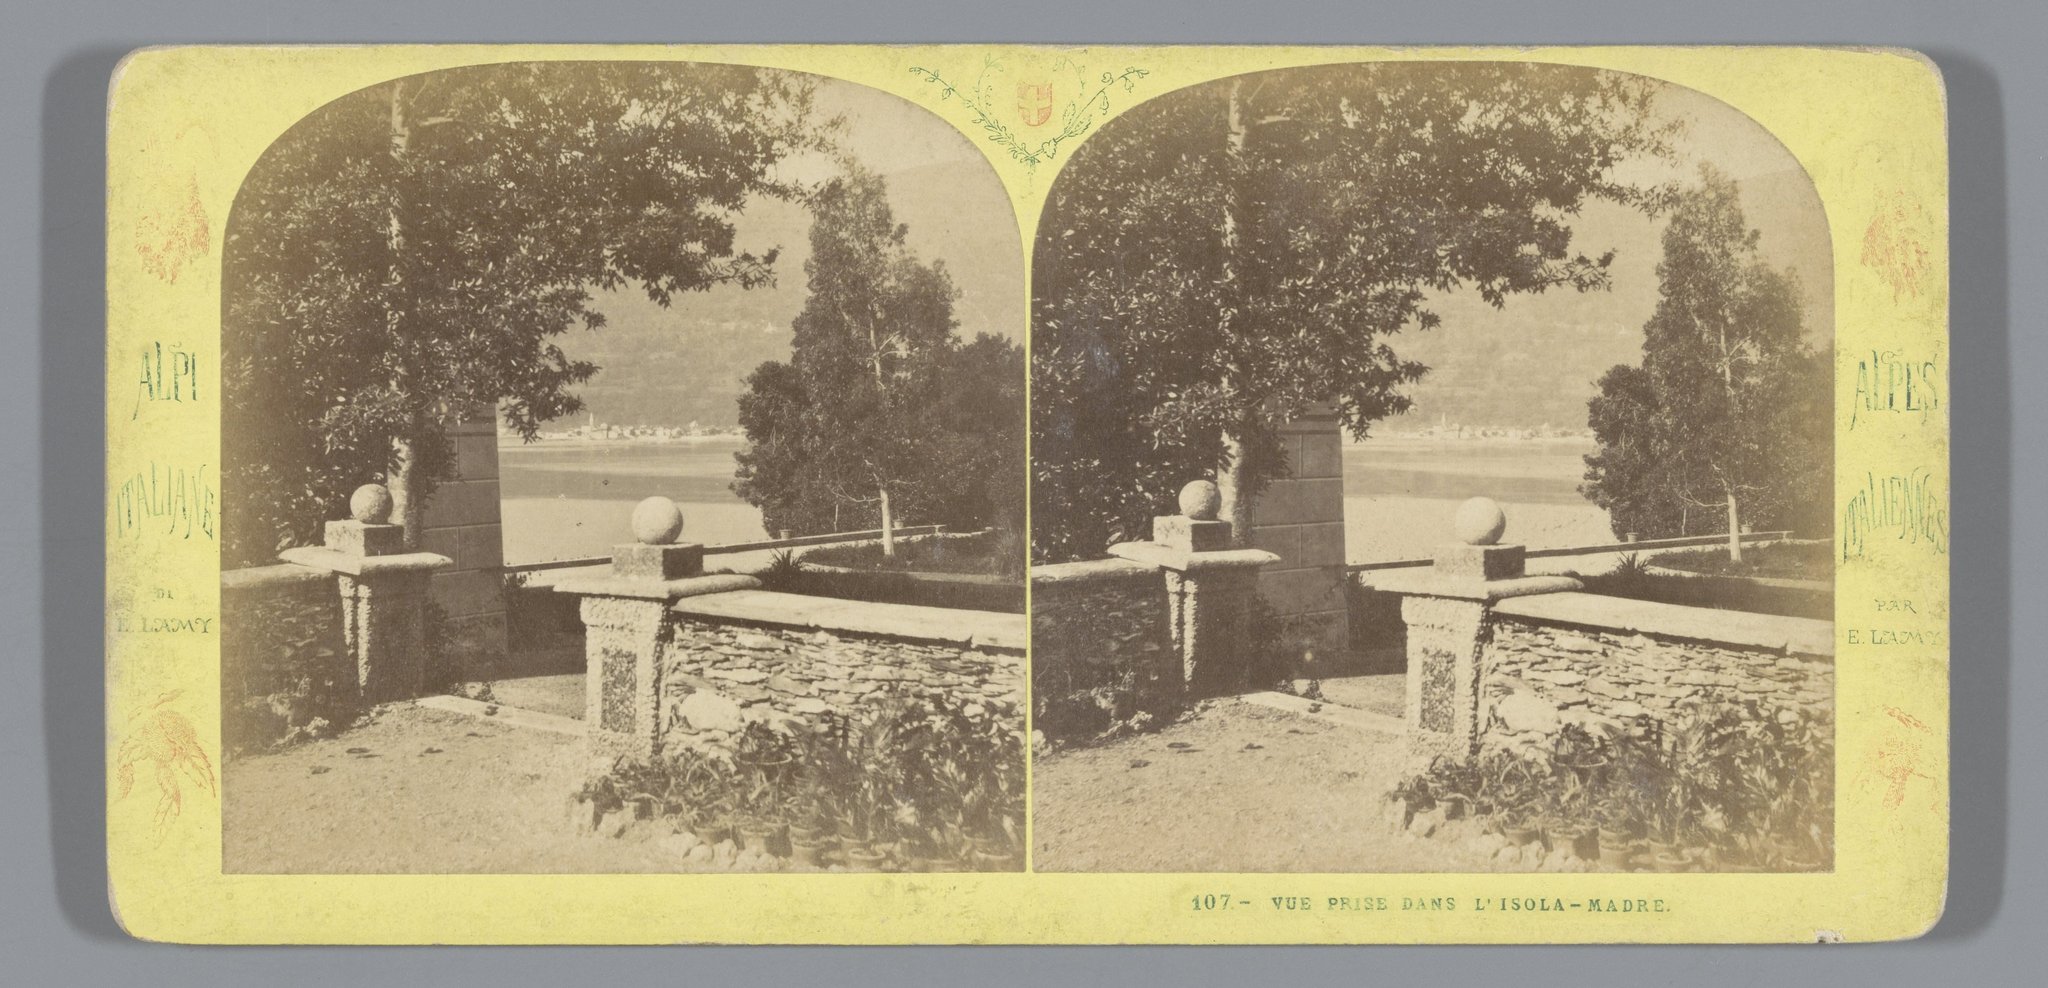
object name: stereograph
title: Alpi Italiane / Alpes Italiennes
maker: ernest eléonor pierre lamy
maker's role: publisher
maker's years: 1828-1900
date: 1861-1878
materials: cardboard, paper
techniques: albumen print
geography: isola madre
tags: trees, lake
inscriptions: number: ‘107.’